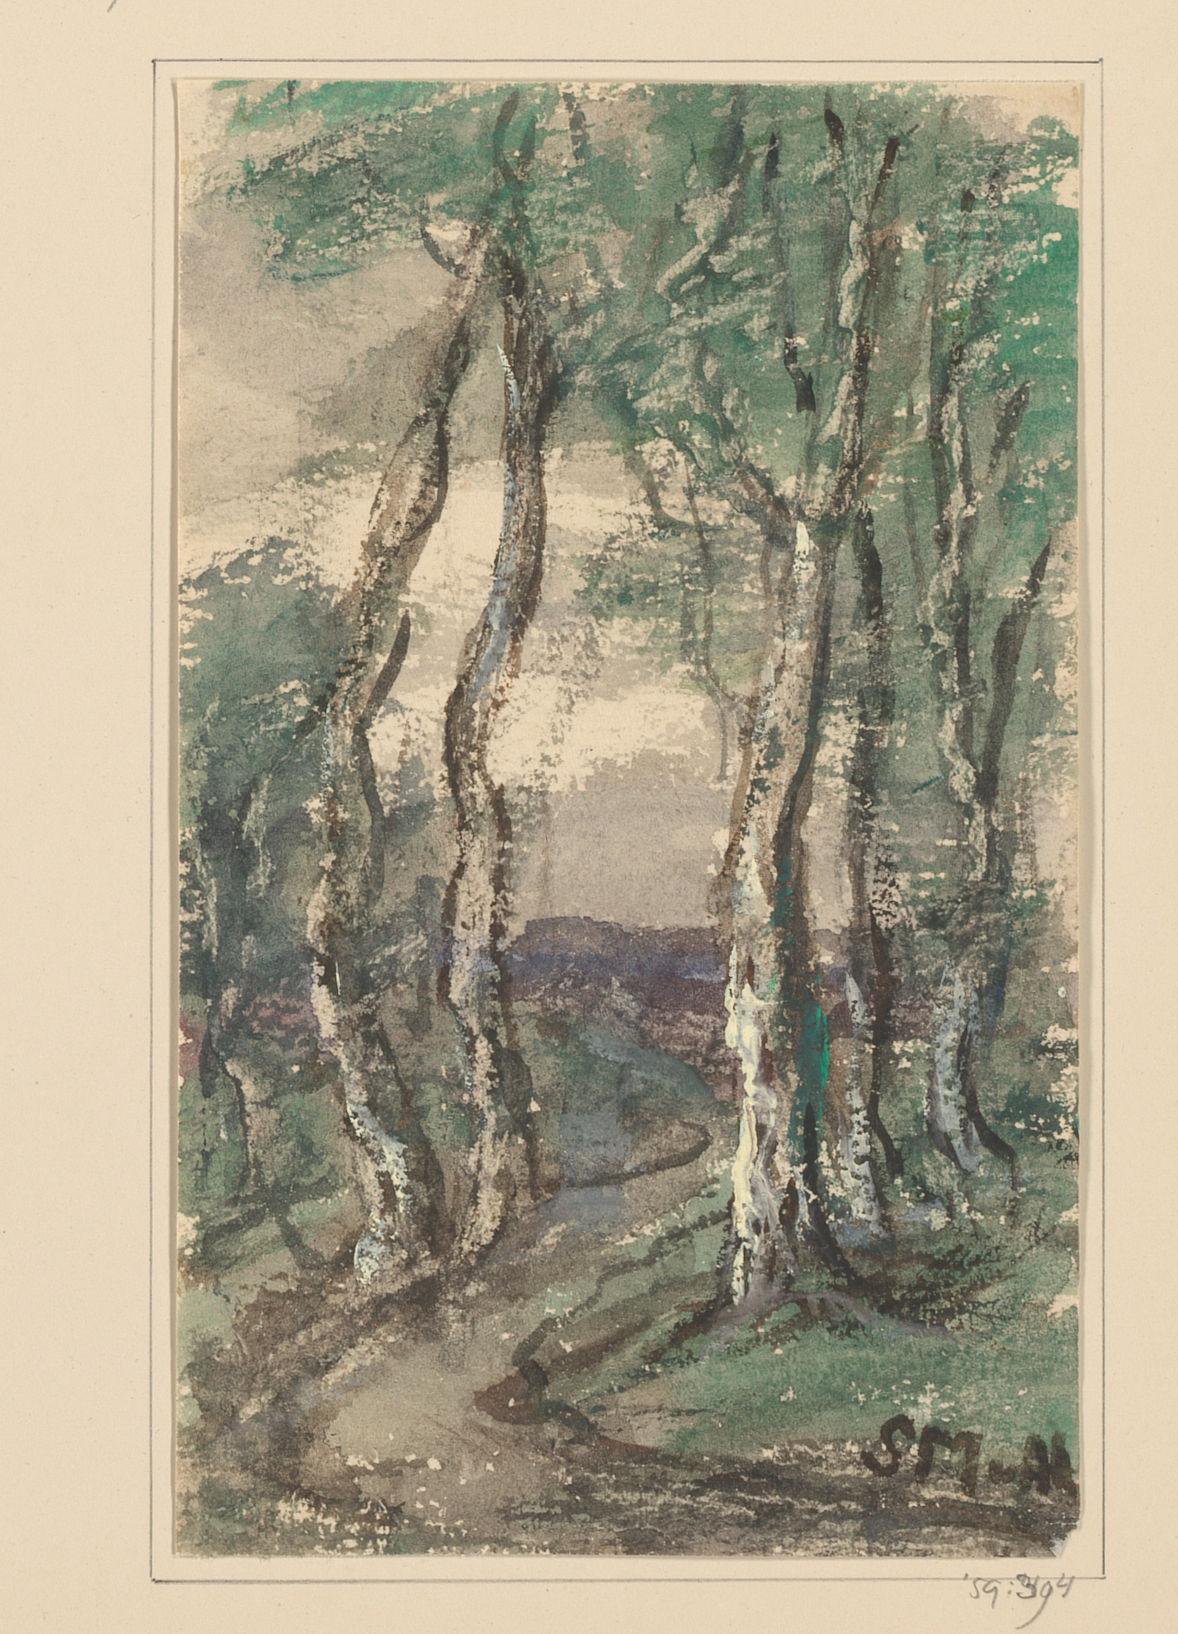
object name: drawing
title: Boslandschap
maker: sientje mesdag-van houten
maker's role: draughtsman, painter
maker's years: 1834-1909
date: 1856-1909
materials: paper, watercolor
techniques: brush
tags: forest, wood